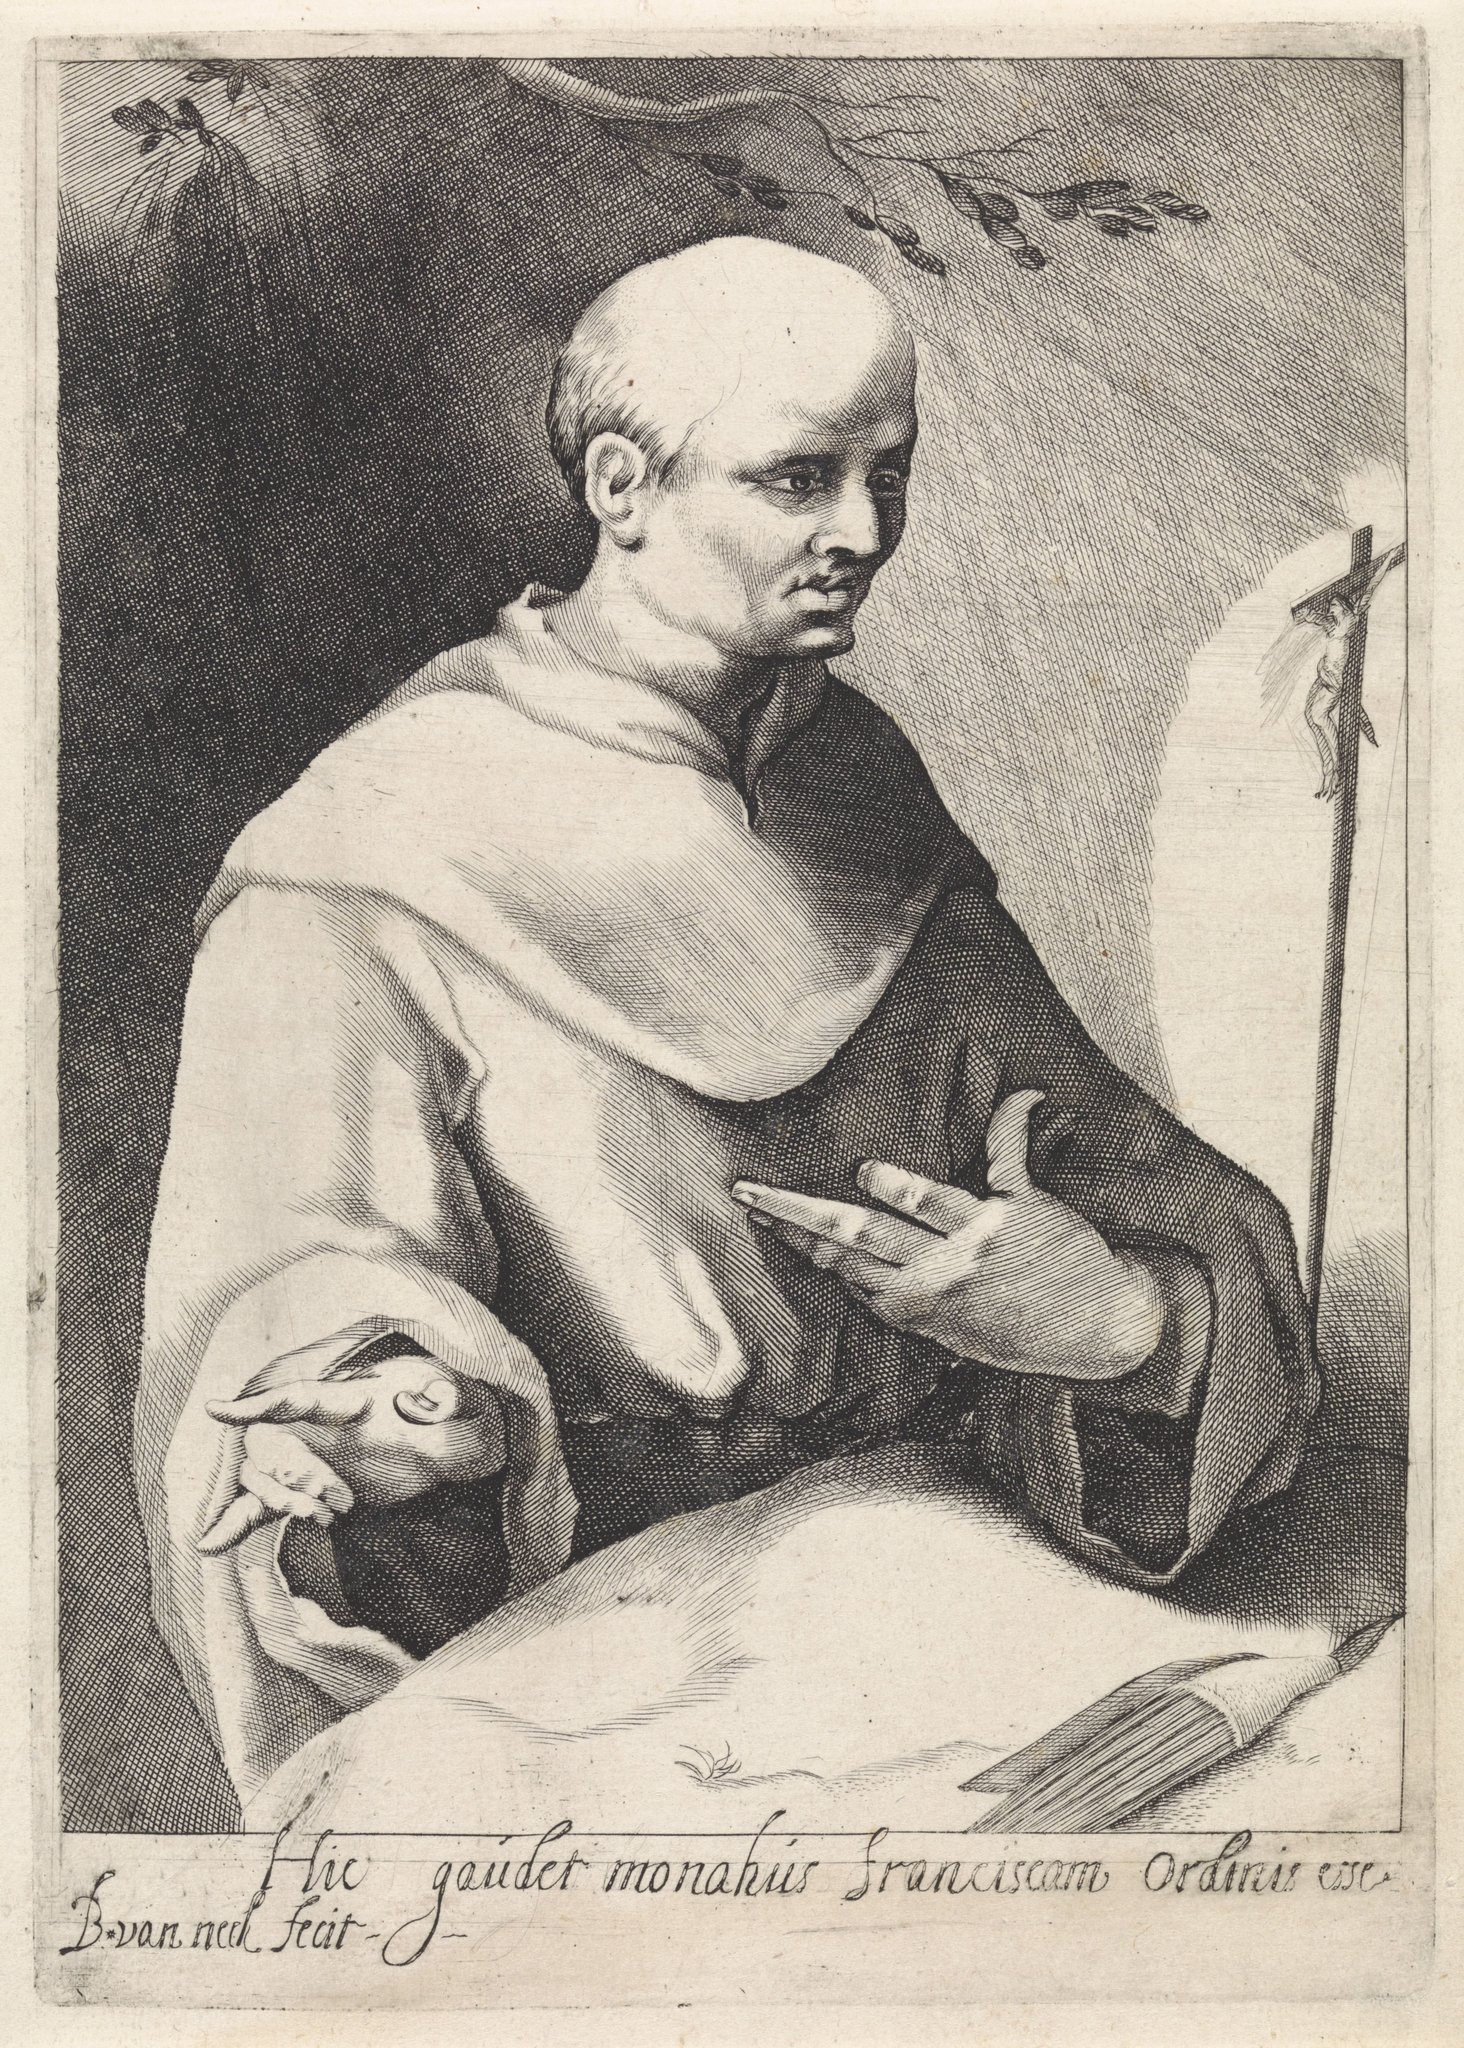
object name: print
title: H. Franciscus van Assisi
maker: b. van neck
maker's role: print maker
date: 1626-1630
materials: paper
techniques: engraving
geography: netherlands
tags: founder of the order of friars minor (franciscans), francis(cus) of assisi; possible attributes: book, crucifix, lily, skull, stigmata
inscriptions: collector's mark: Lugt 2228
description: De heilige Franciscus van Assisi bij een crucifix en een opengeslagen boek.